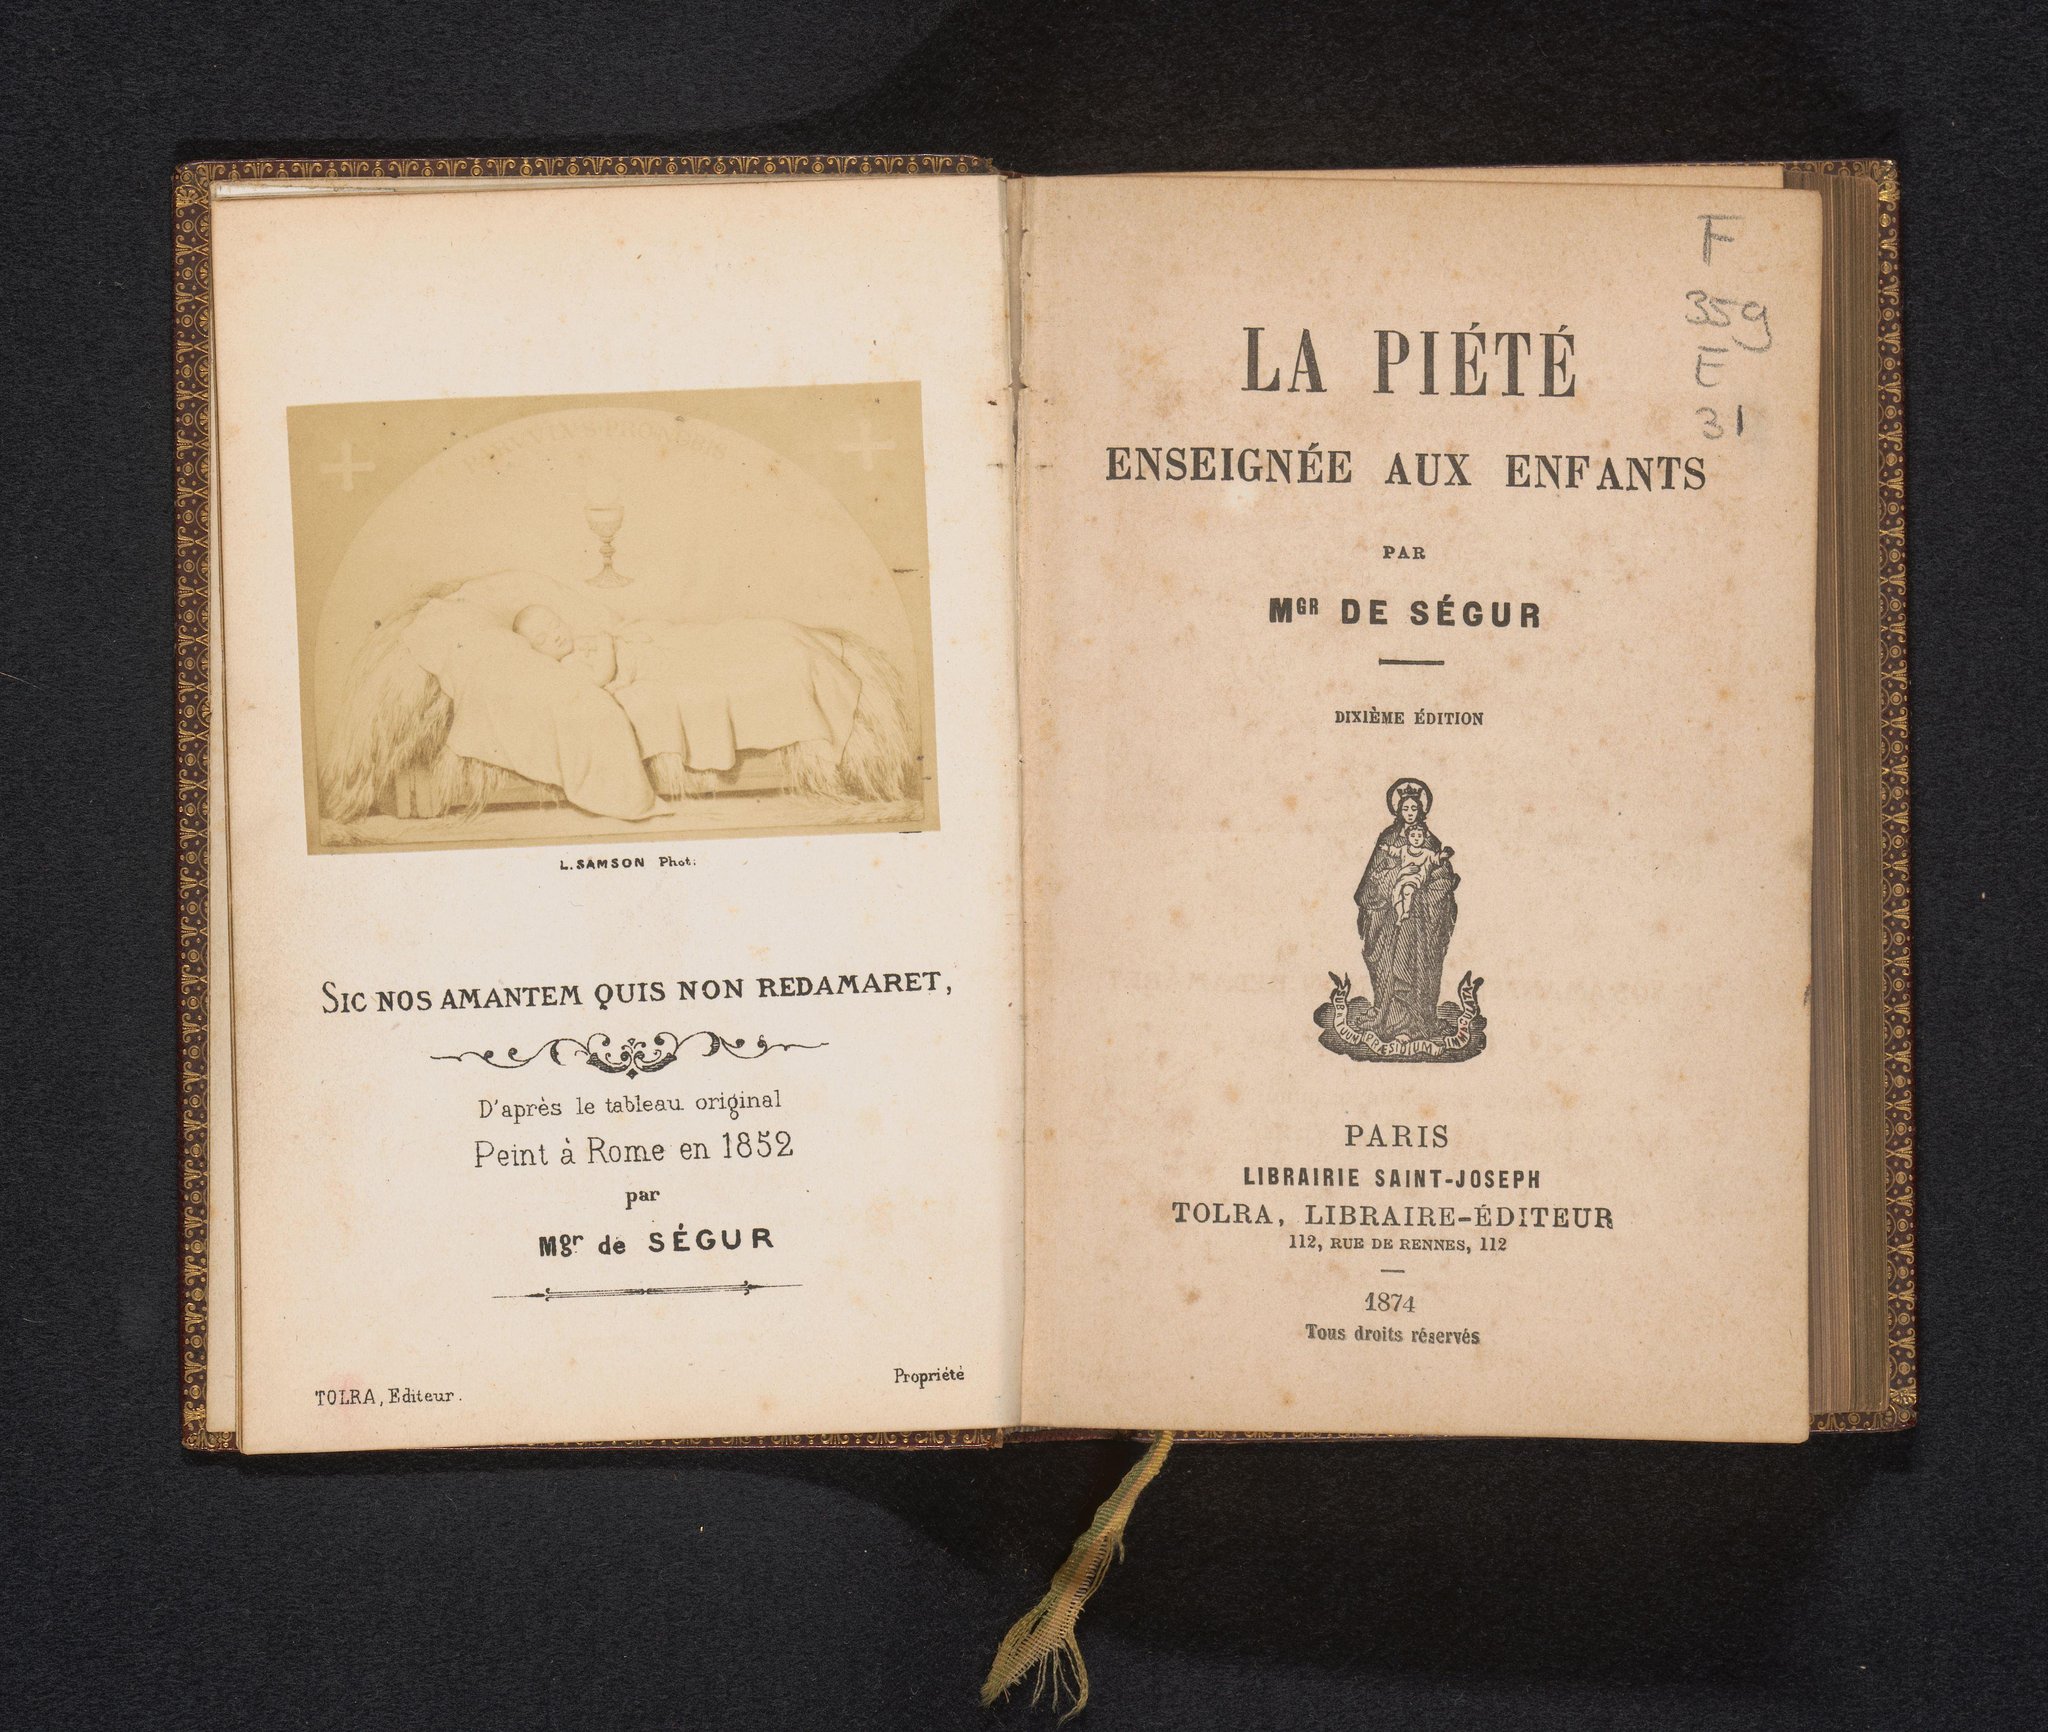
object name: book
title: La piété enseignée aux enfants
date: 1874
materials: cardboard, leather, paper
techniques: printing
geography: paris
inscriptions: annotation: ‘NOV 2005’